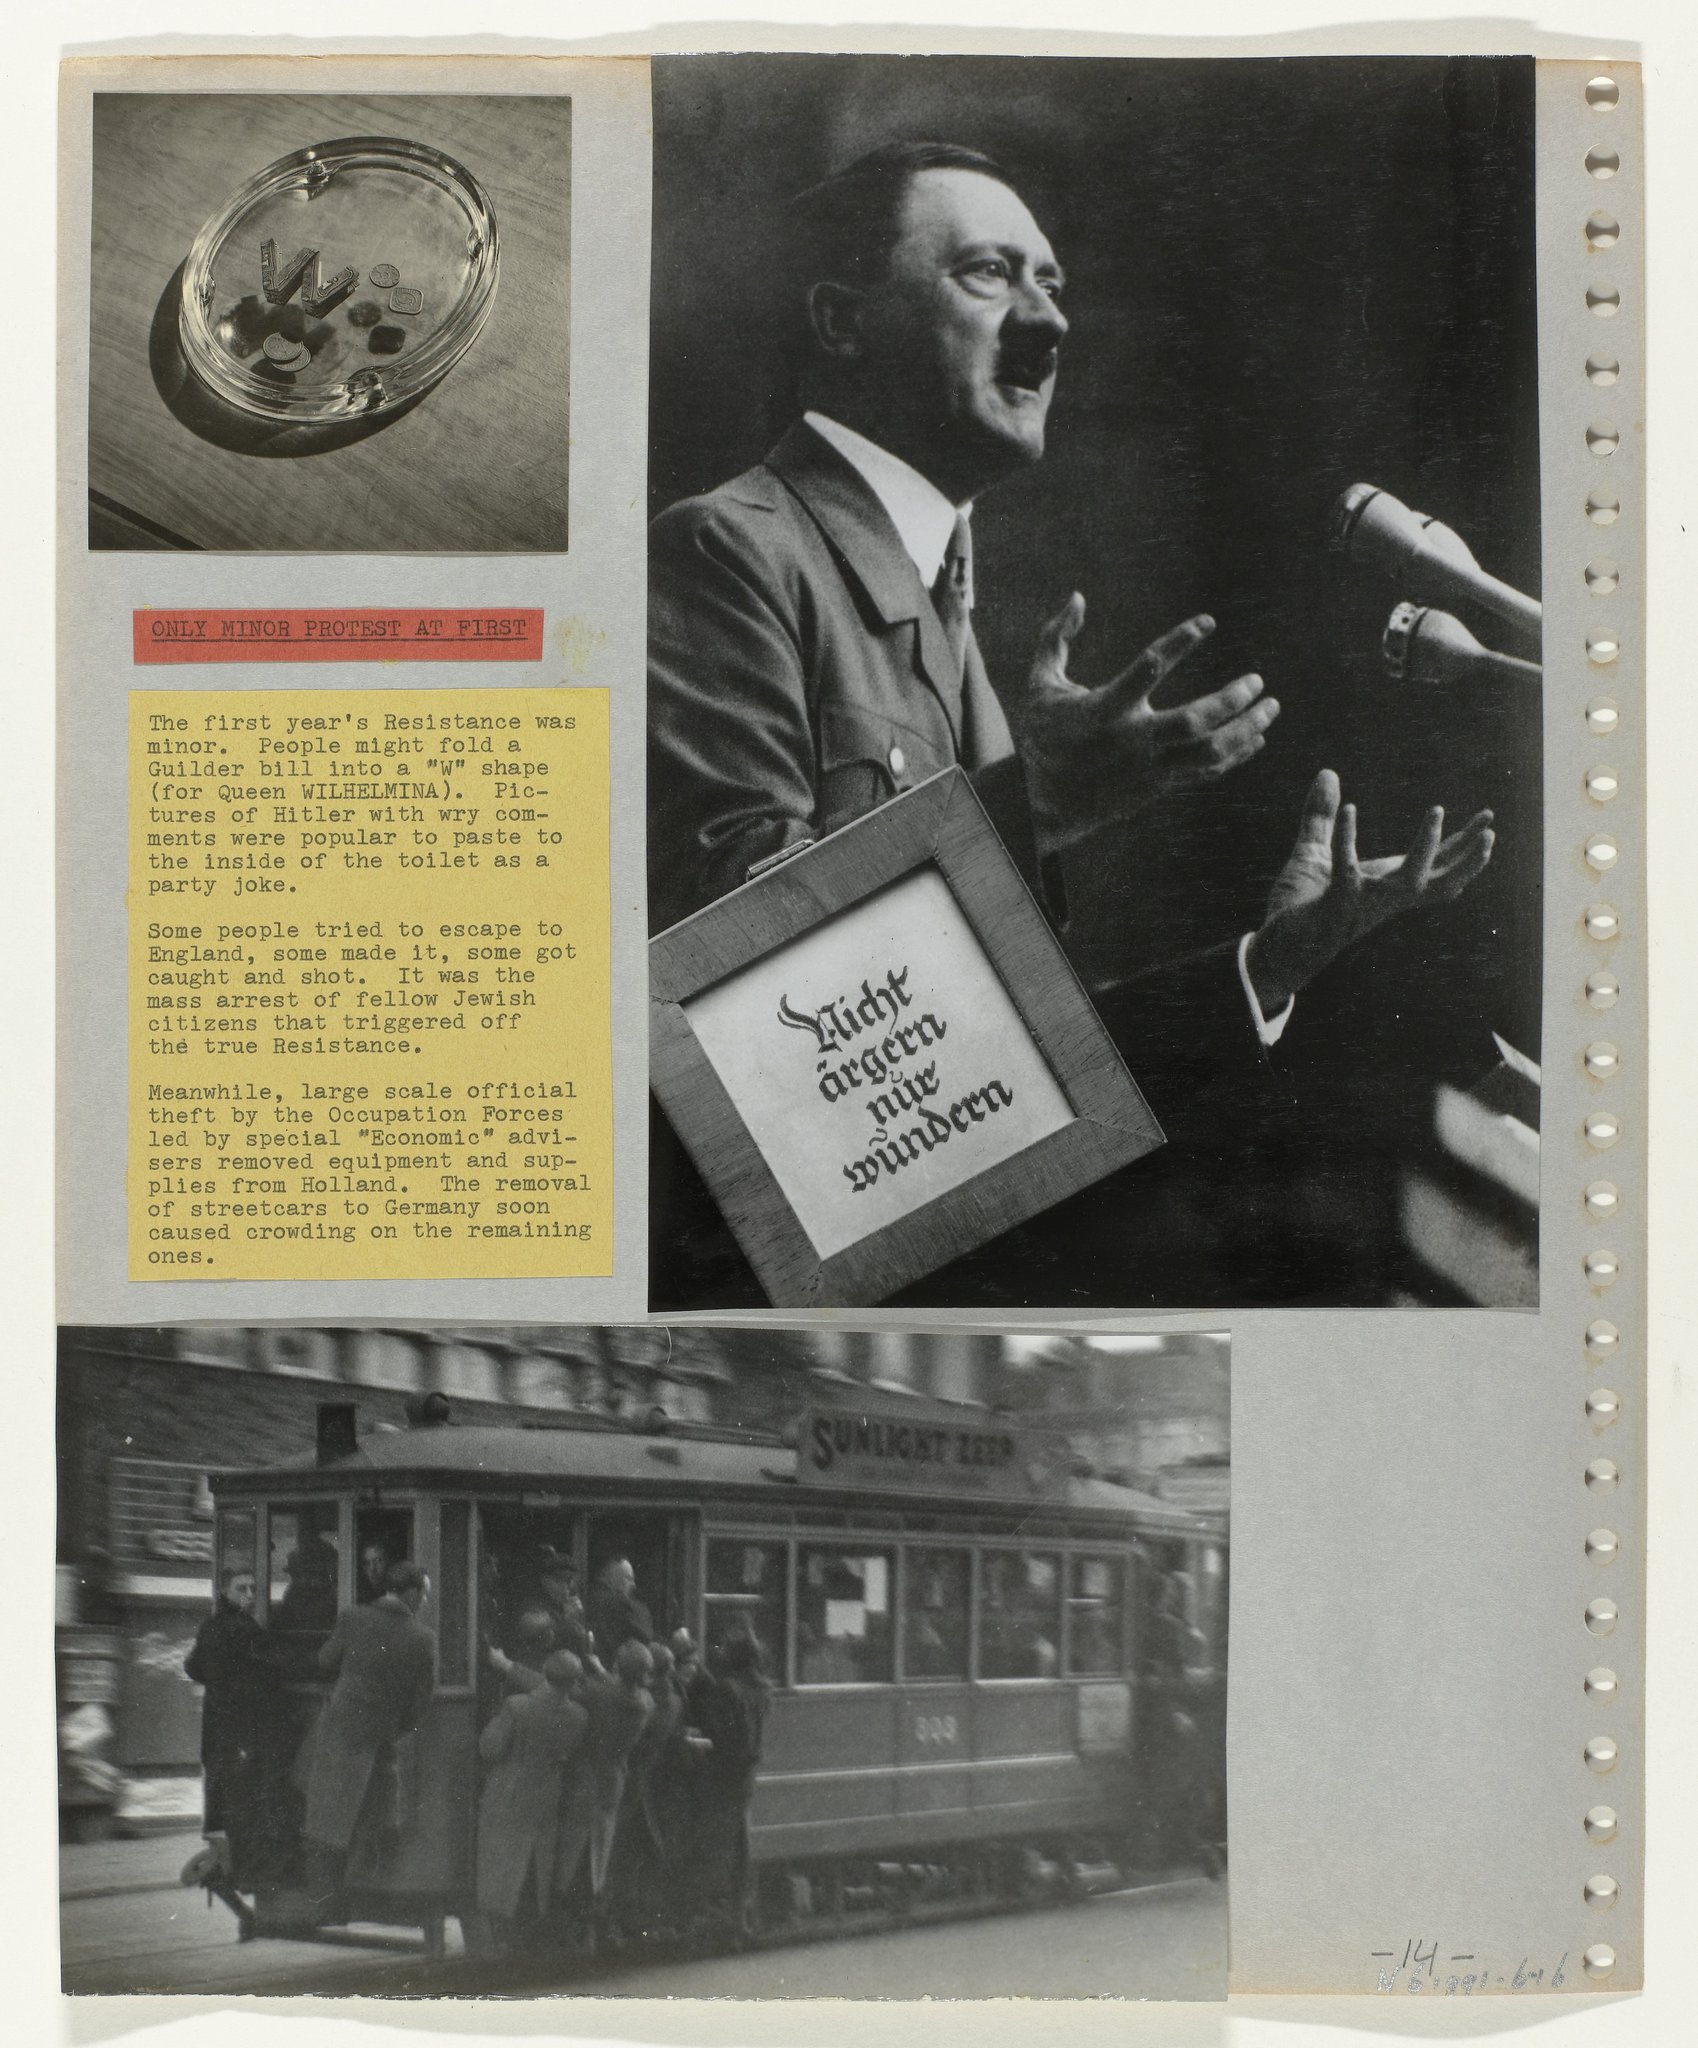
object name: photograph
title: Het kleine verzet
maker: Anonymous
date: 1940-1945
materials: paper, plastic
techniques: photography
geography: netherlands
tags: amsterdam, tonny van renterghem, politician, adolf hitler, fritz kahlenberg, tram, underground movement, partisans, historical persons, netherlands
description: Twee foto's die iets laten zien van het verzet binnenhuis: de "W" van Wilhelmina gevouwen uit een papieren guldenbiljet (l.b.) en een foto van Hitler met als bijschrift: Nicht ärgern, nur wundern (r.b.). Een derde foto toont een tram die overvol is omdat veel tramwagons naar Duitsland verdwenen (onder).